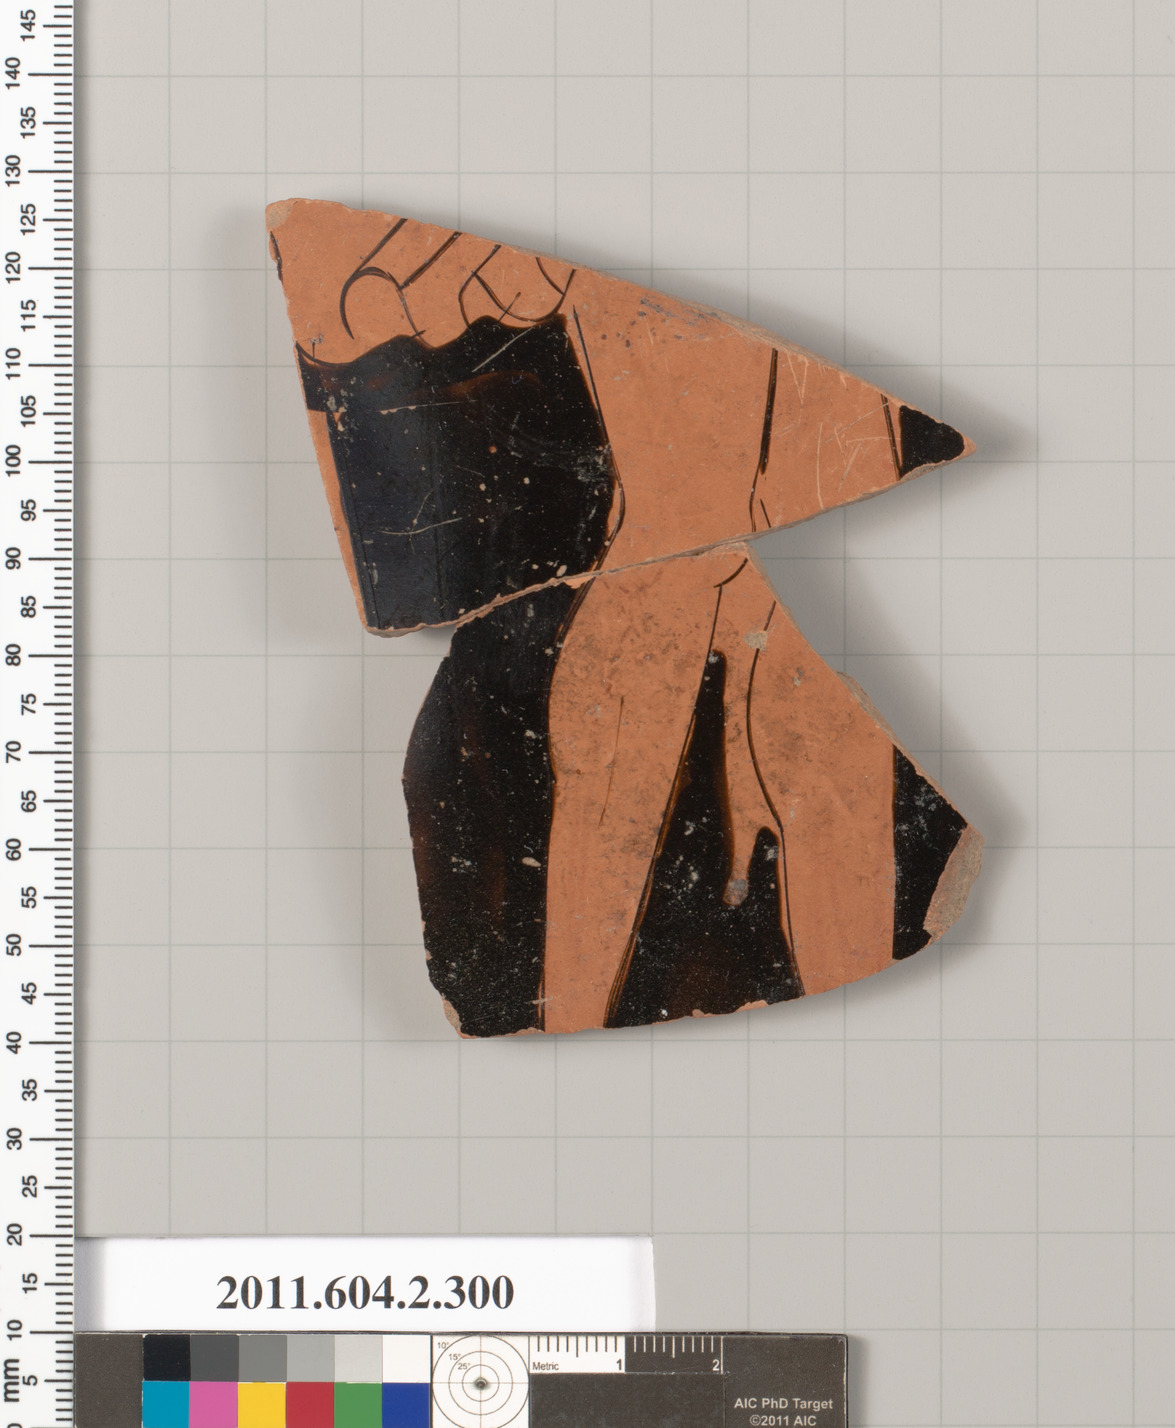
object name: column krater fragment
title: Terracotta fragment of a column-krater (bowl for mixing wine and water)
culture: greek, attic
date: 460-440 BCE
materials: terracotta